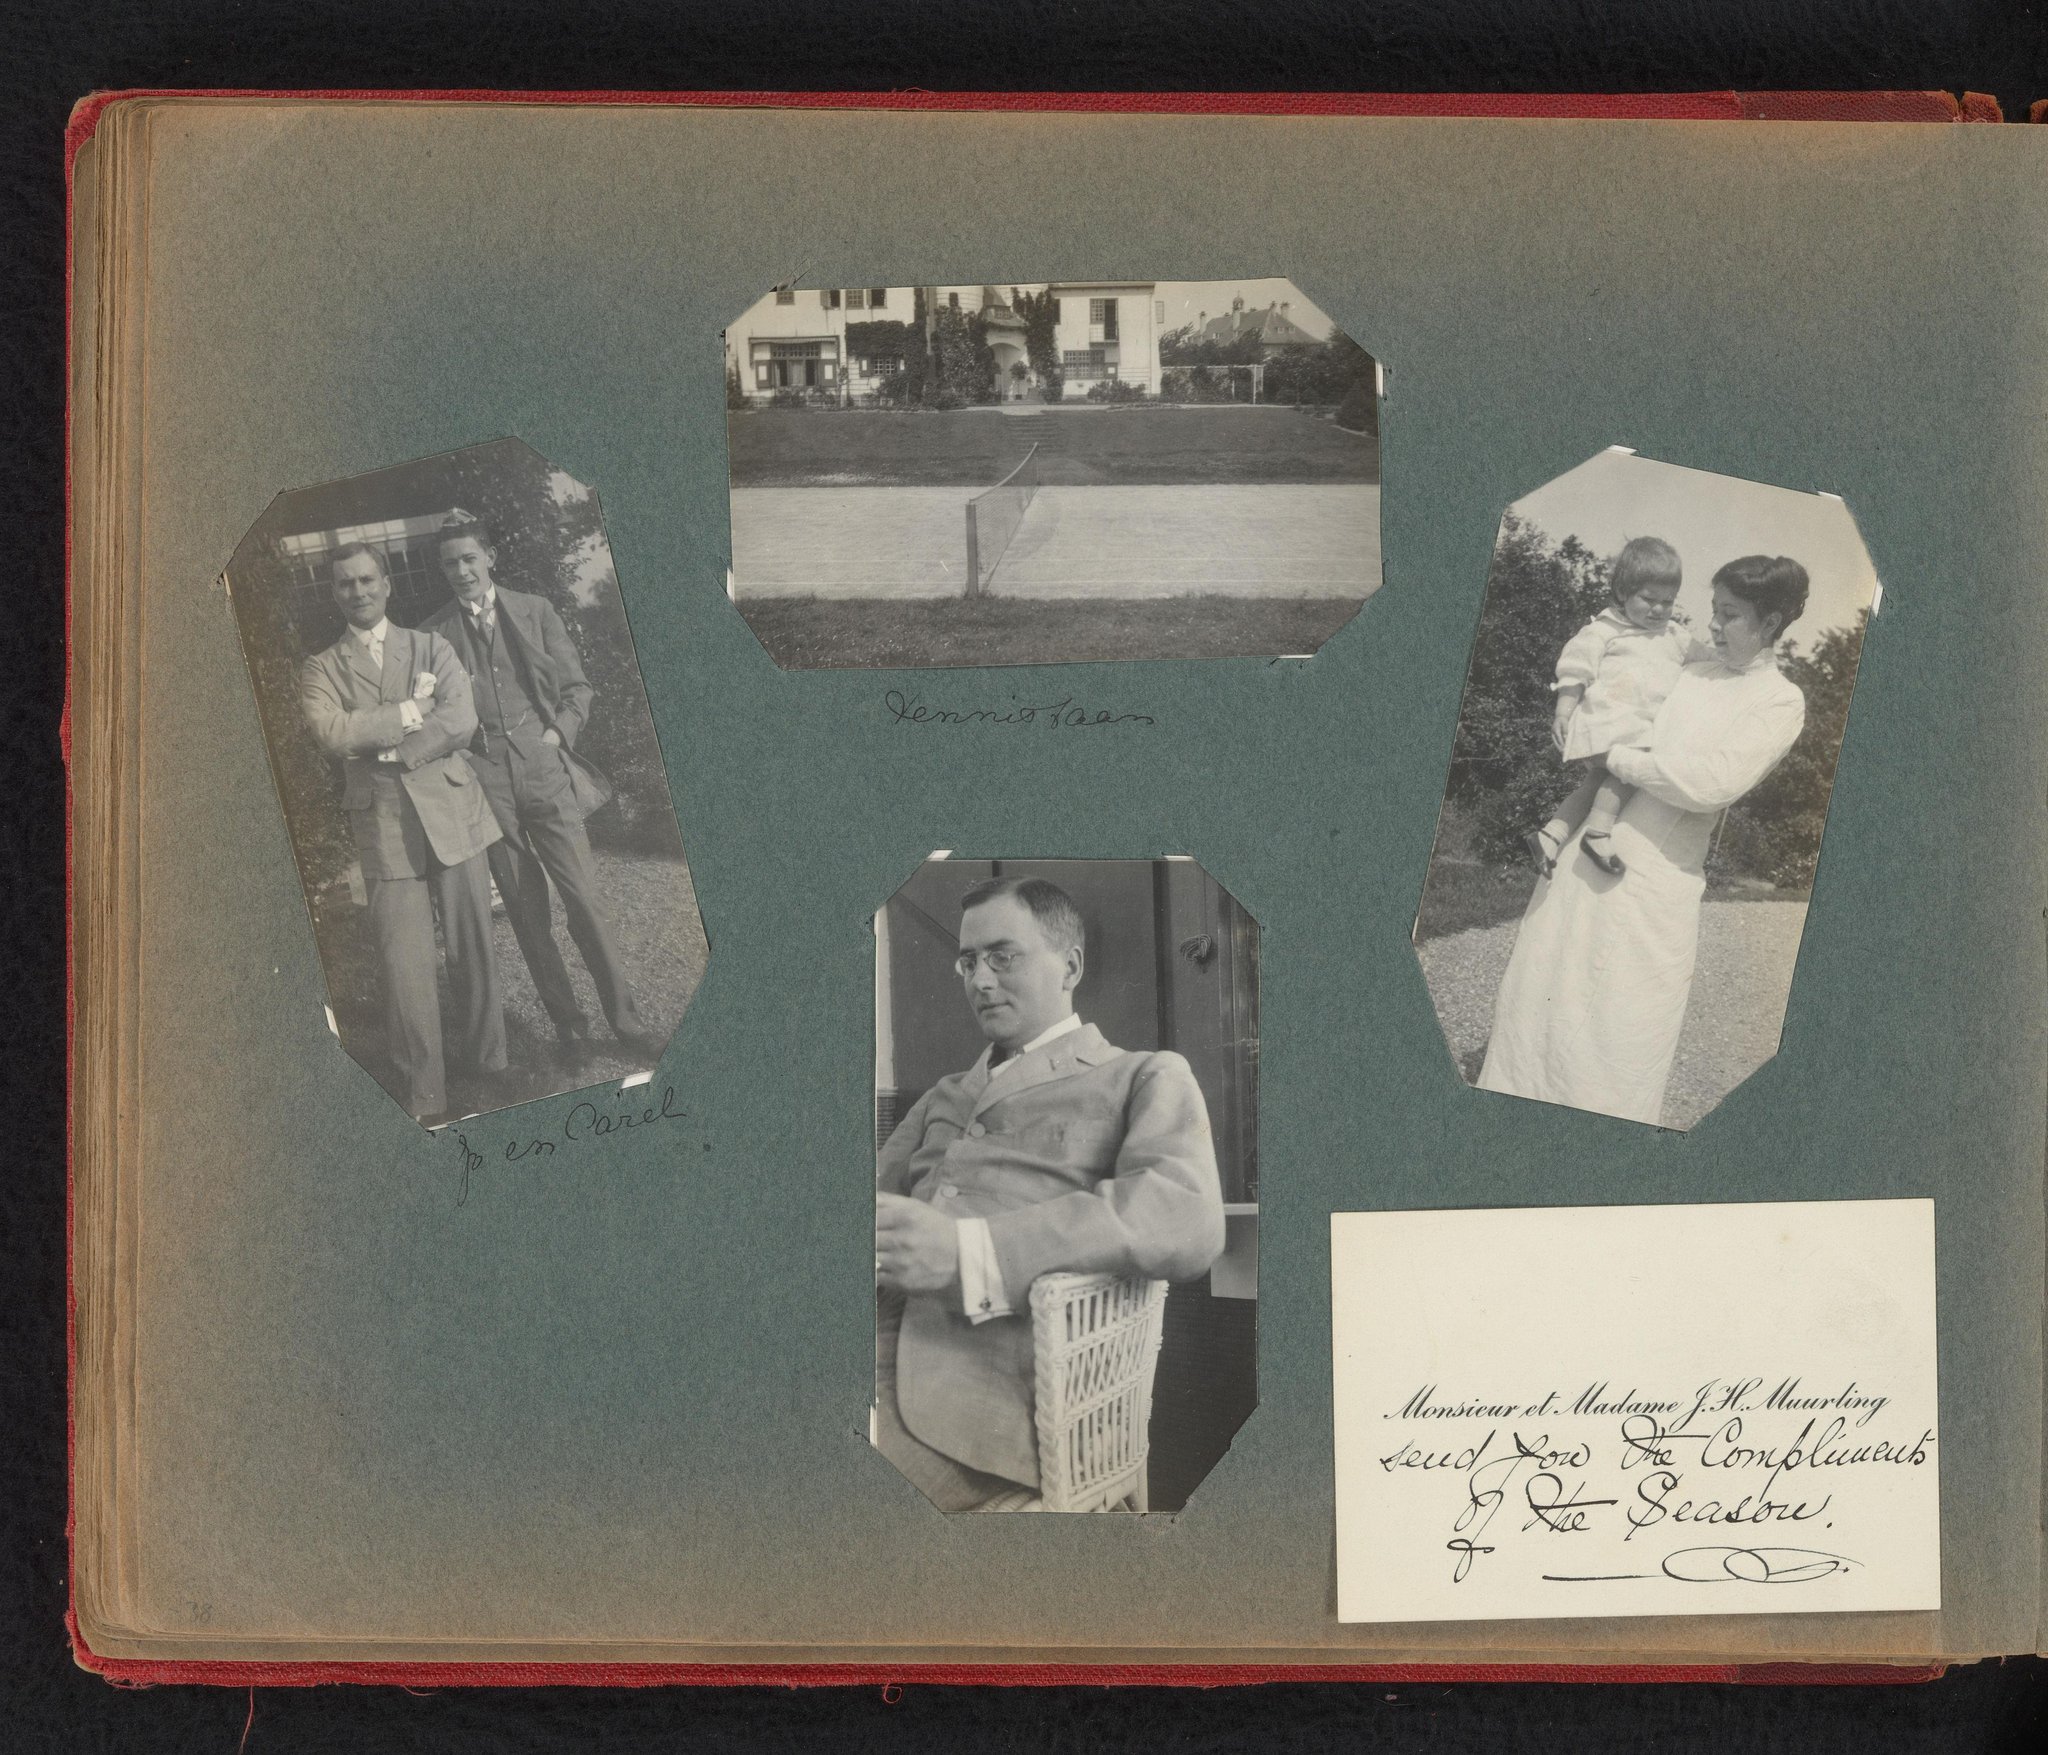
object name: album leaf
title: Vier taferelen met Eva, Charlotte en Joan Boelen bij Huis Sonnevanck in Aerdenhout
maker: charlotte alida boelen-matthes (lot)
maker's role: amateurfotograaf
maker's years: 1889-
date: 1913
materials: paper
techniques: gelatin silver print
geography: aerdenhout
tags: amsterdam, eva charlotte pennink-boelen, charlotte alida boelen-matthes (lot), joan gerard boelen, tennis, lawn-tennis, garden, toddler (female)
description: Deze foto's zijn onderdeel van een album.